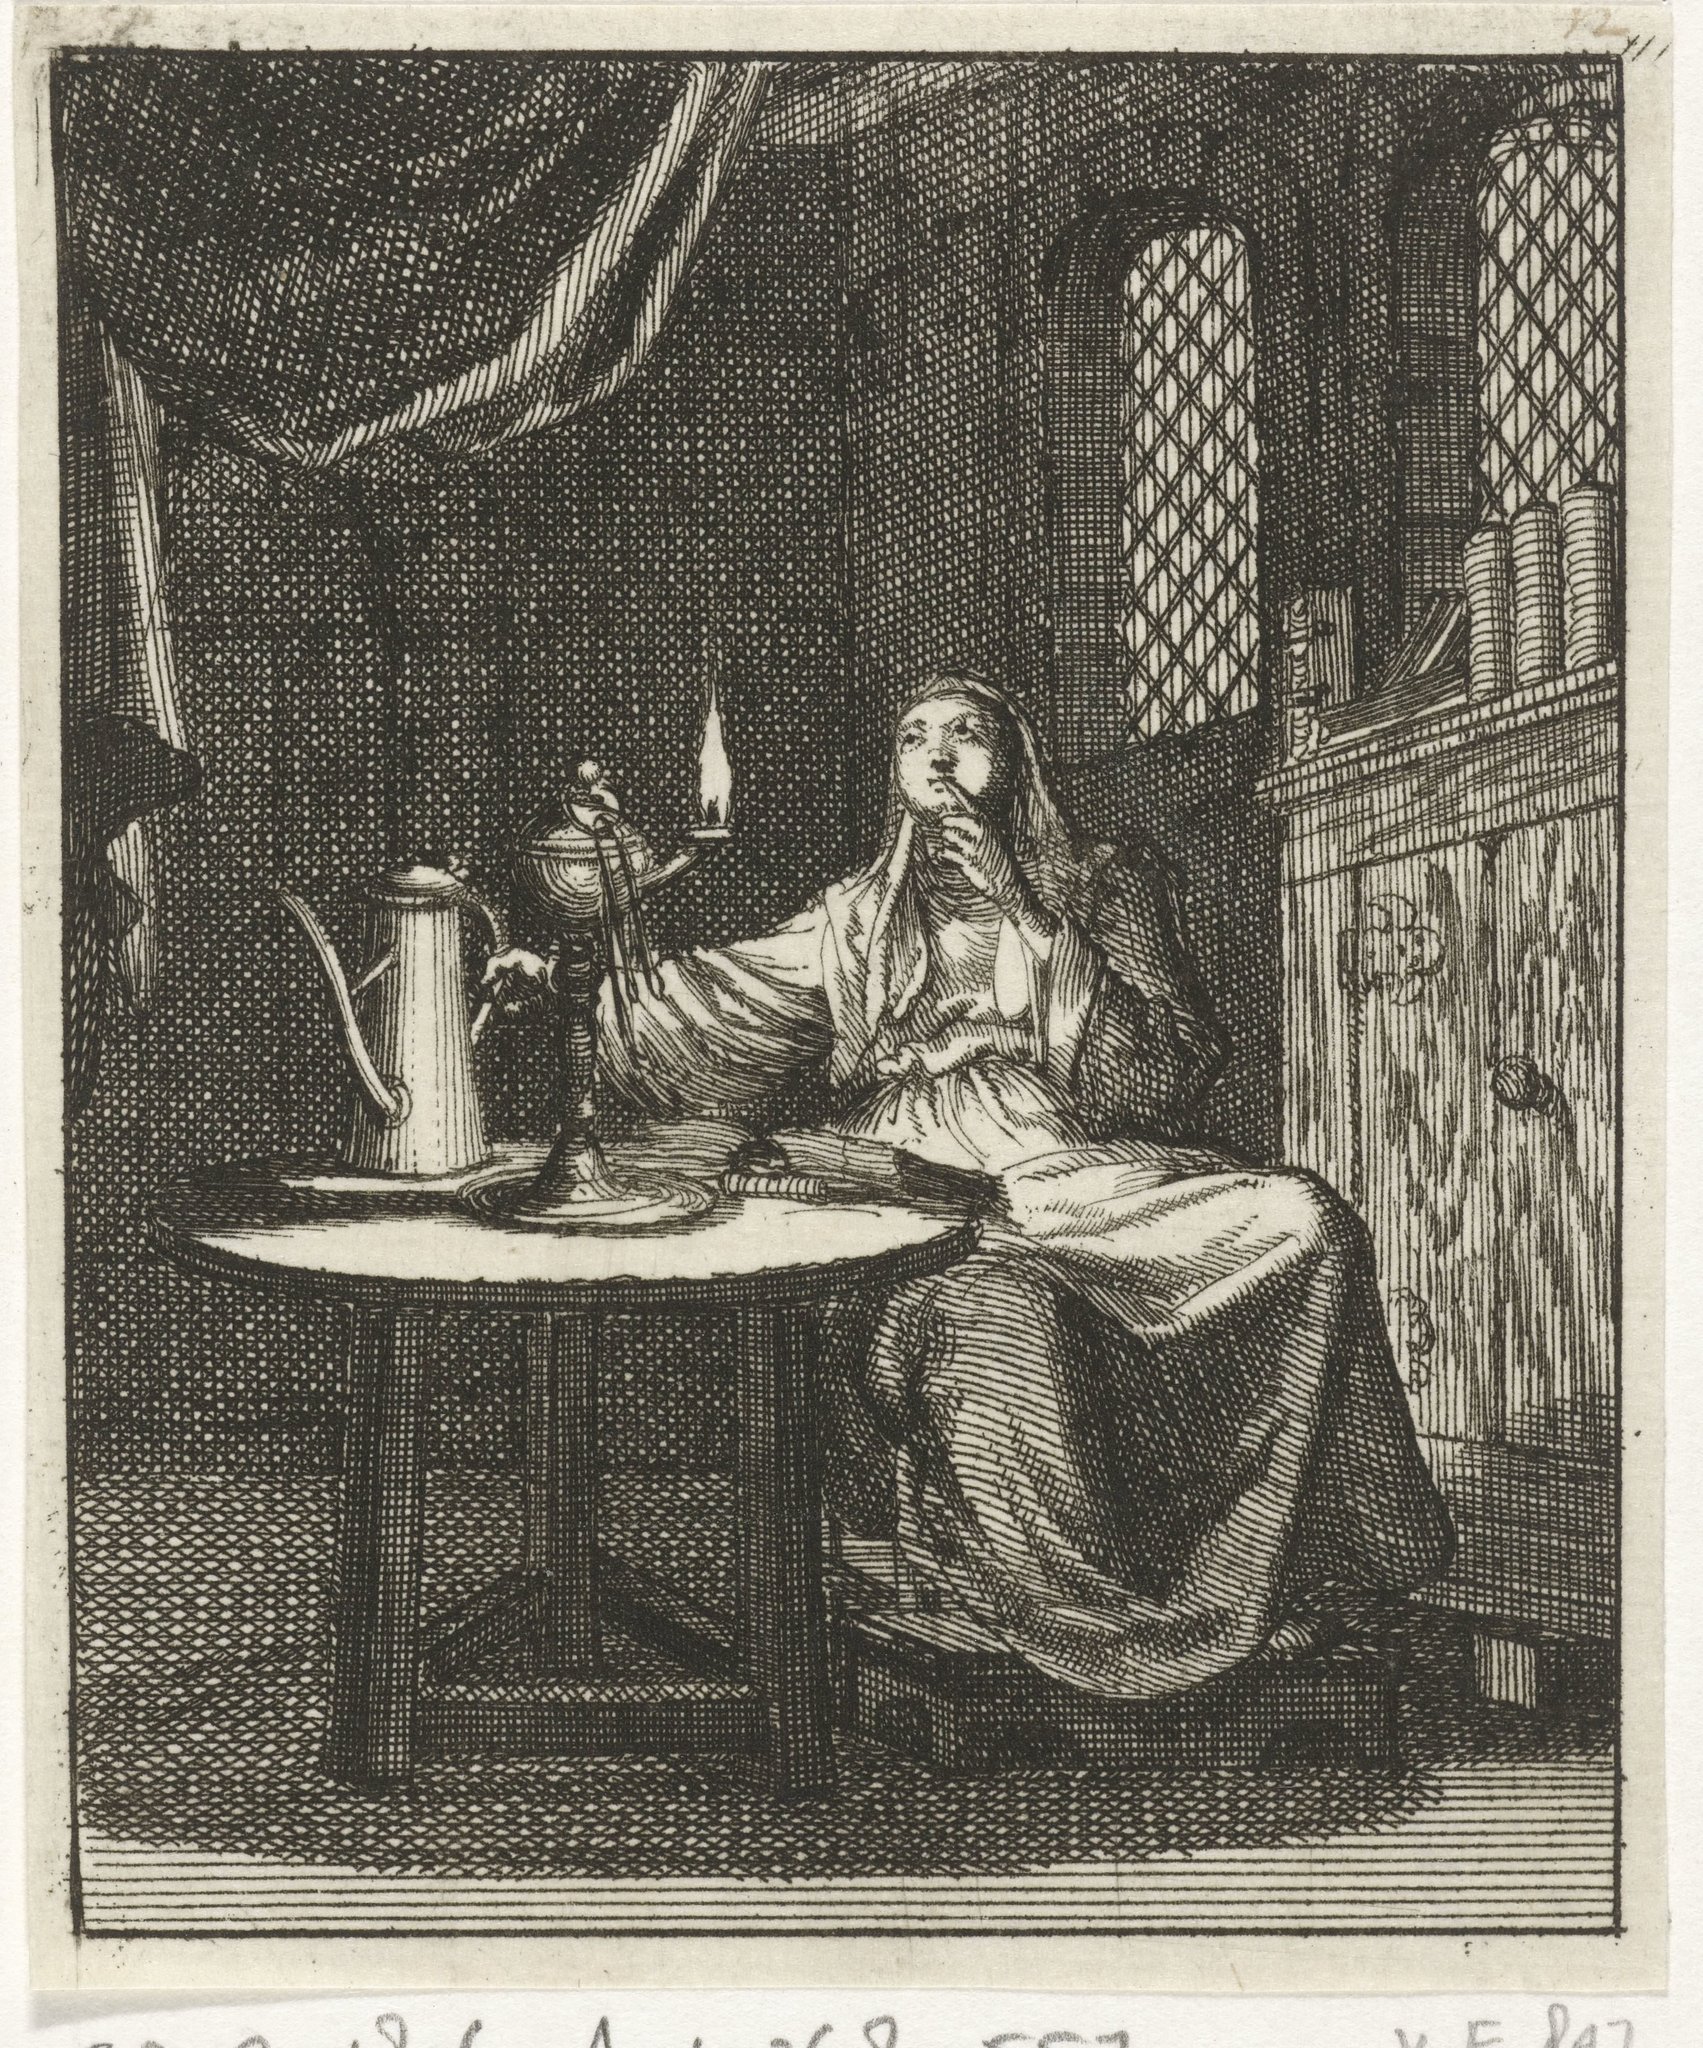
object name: book illustration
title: Nu schynt het klaer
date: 1687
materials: paper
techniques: etching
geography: amsterdam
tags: oil-lamp, flame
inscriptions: number: ‘12’, collector's mark: Lugt 2228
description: Illustratie uit: Luyken, Jan. Voncken der liefde Jesu, van het godtbegerende zielenvier. Amsterdam: Pieter Arentsz (II), 1687, p. 46.